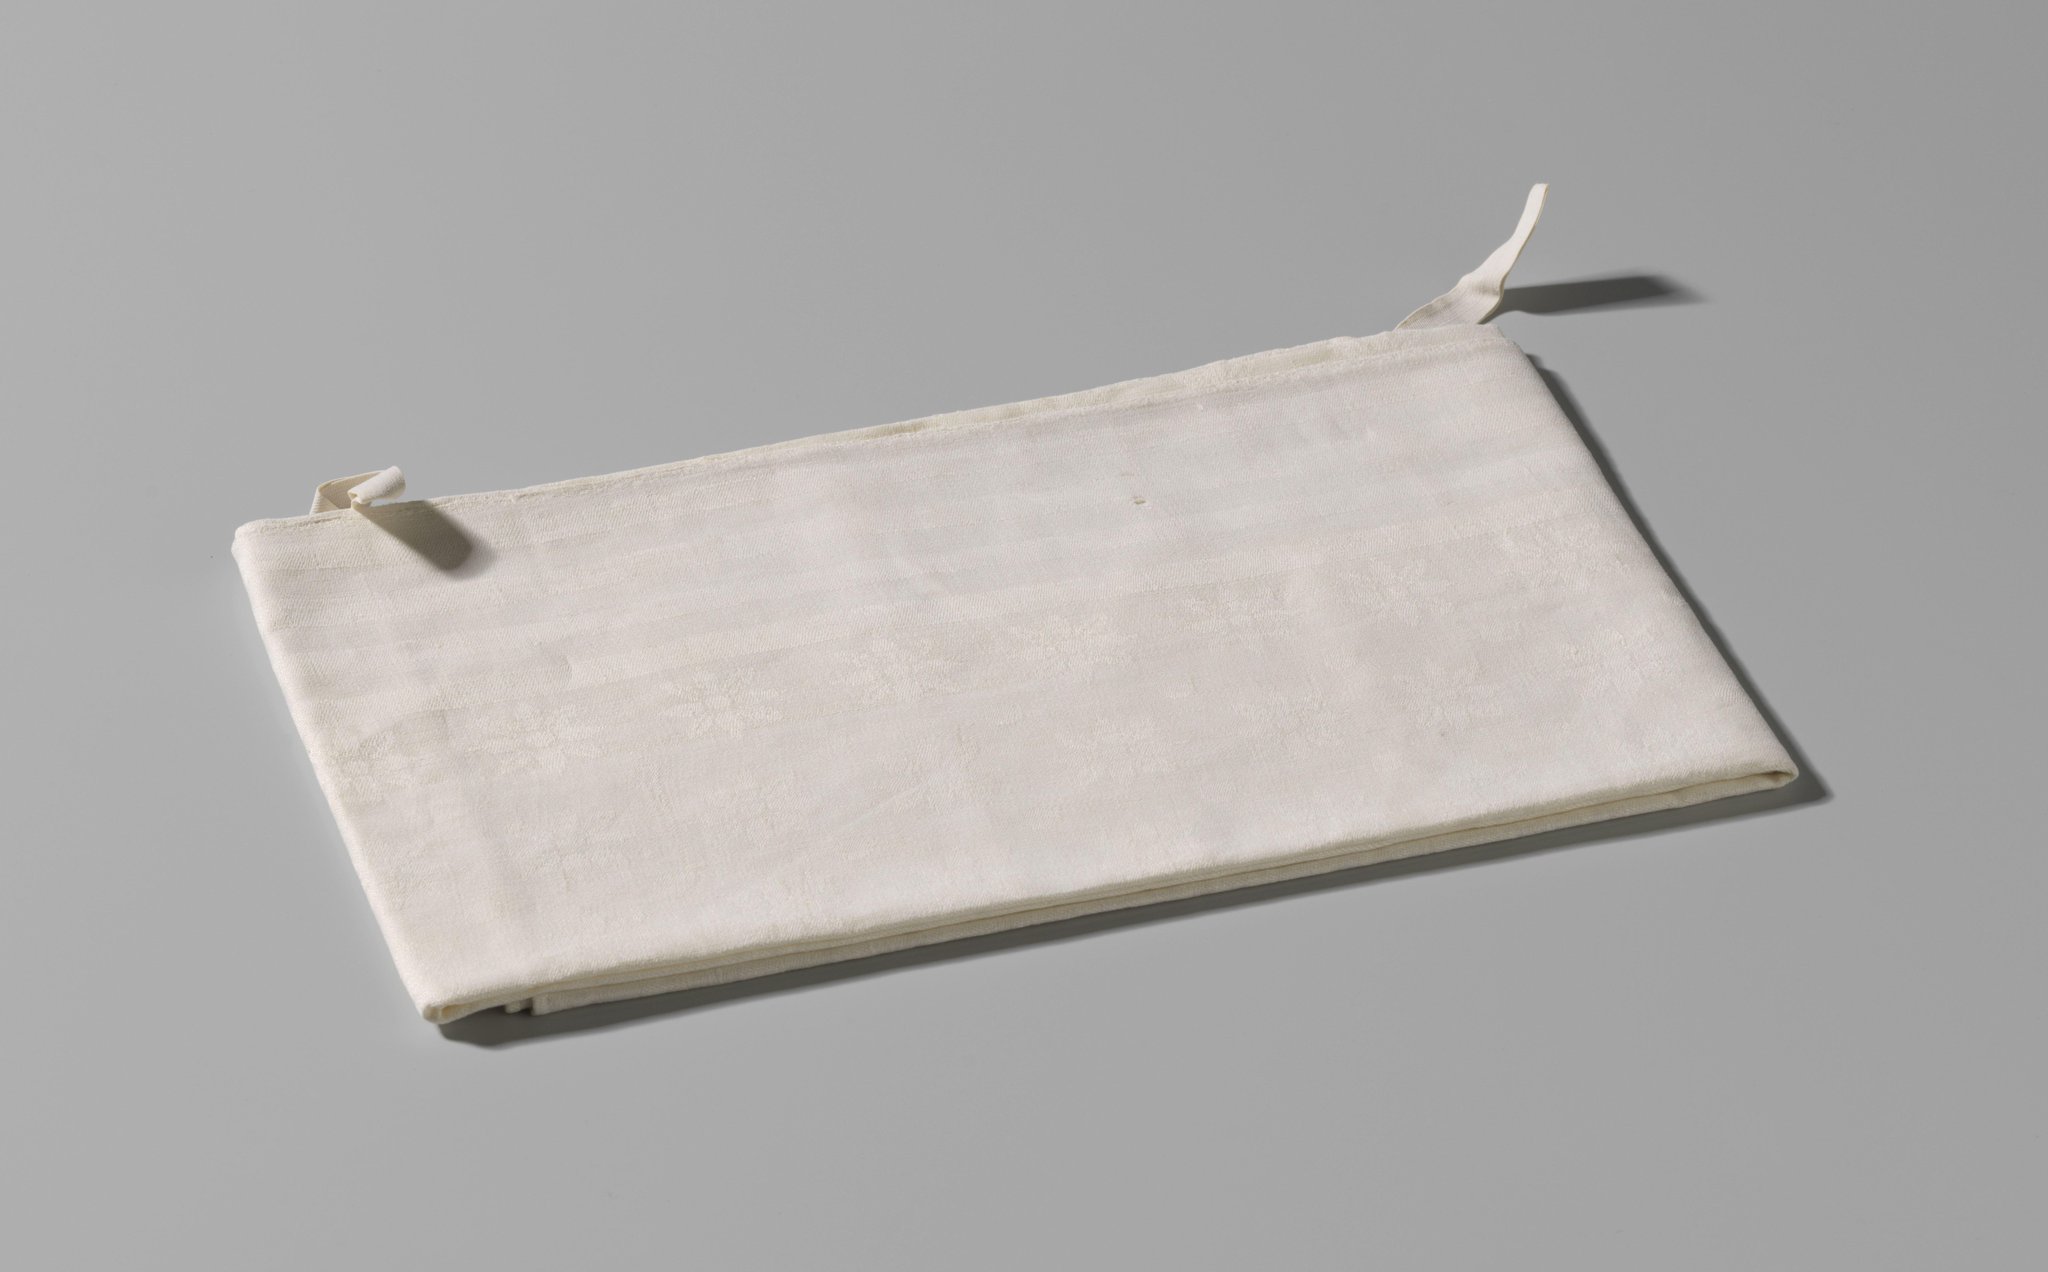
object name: woven material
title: Handdoek van linnendamast, gemerkt met RM of RH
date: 1400-1950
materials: linen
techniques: damask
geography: netherlands